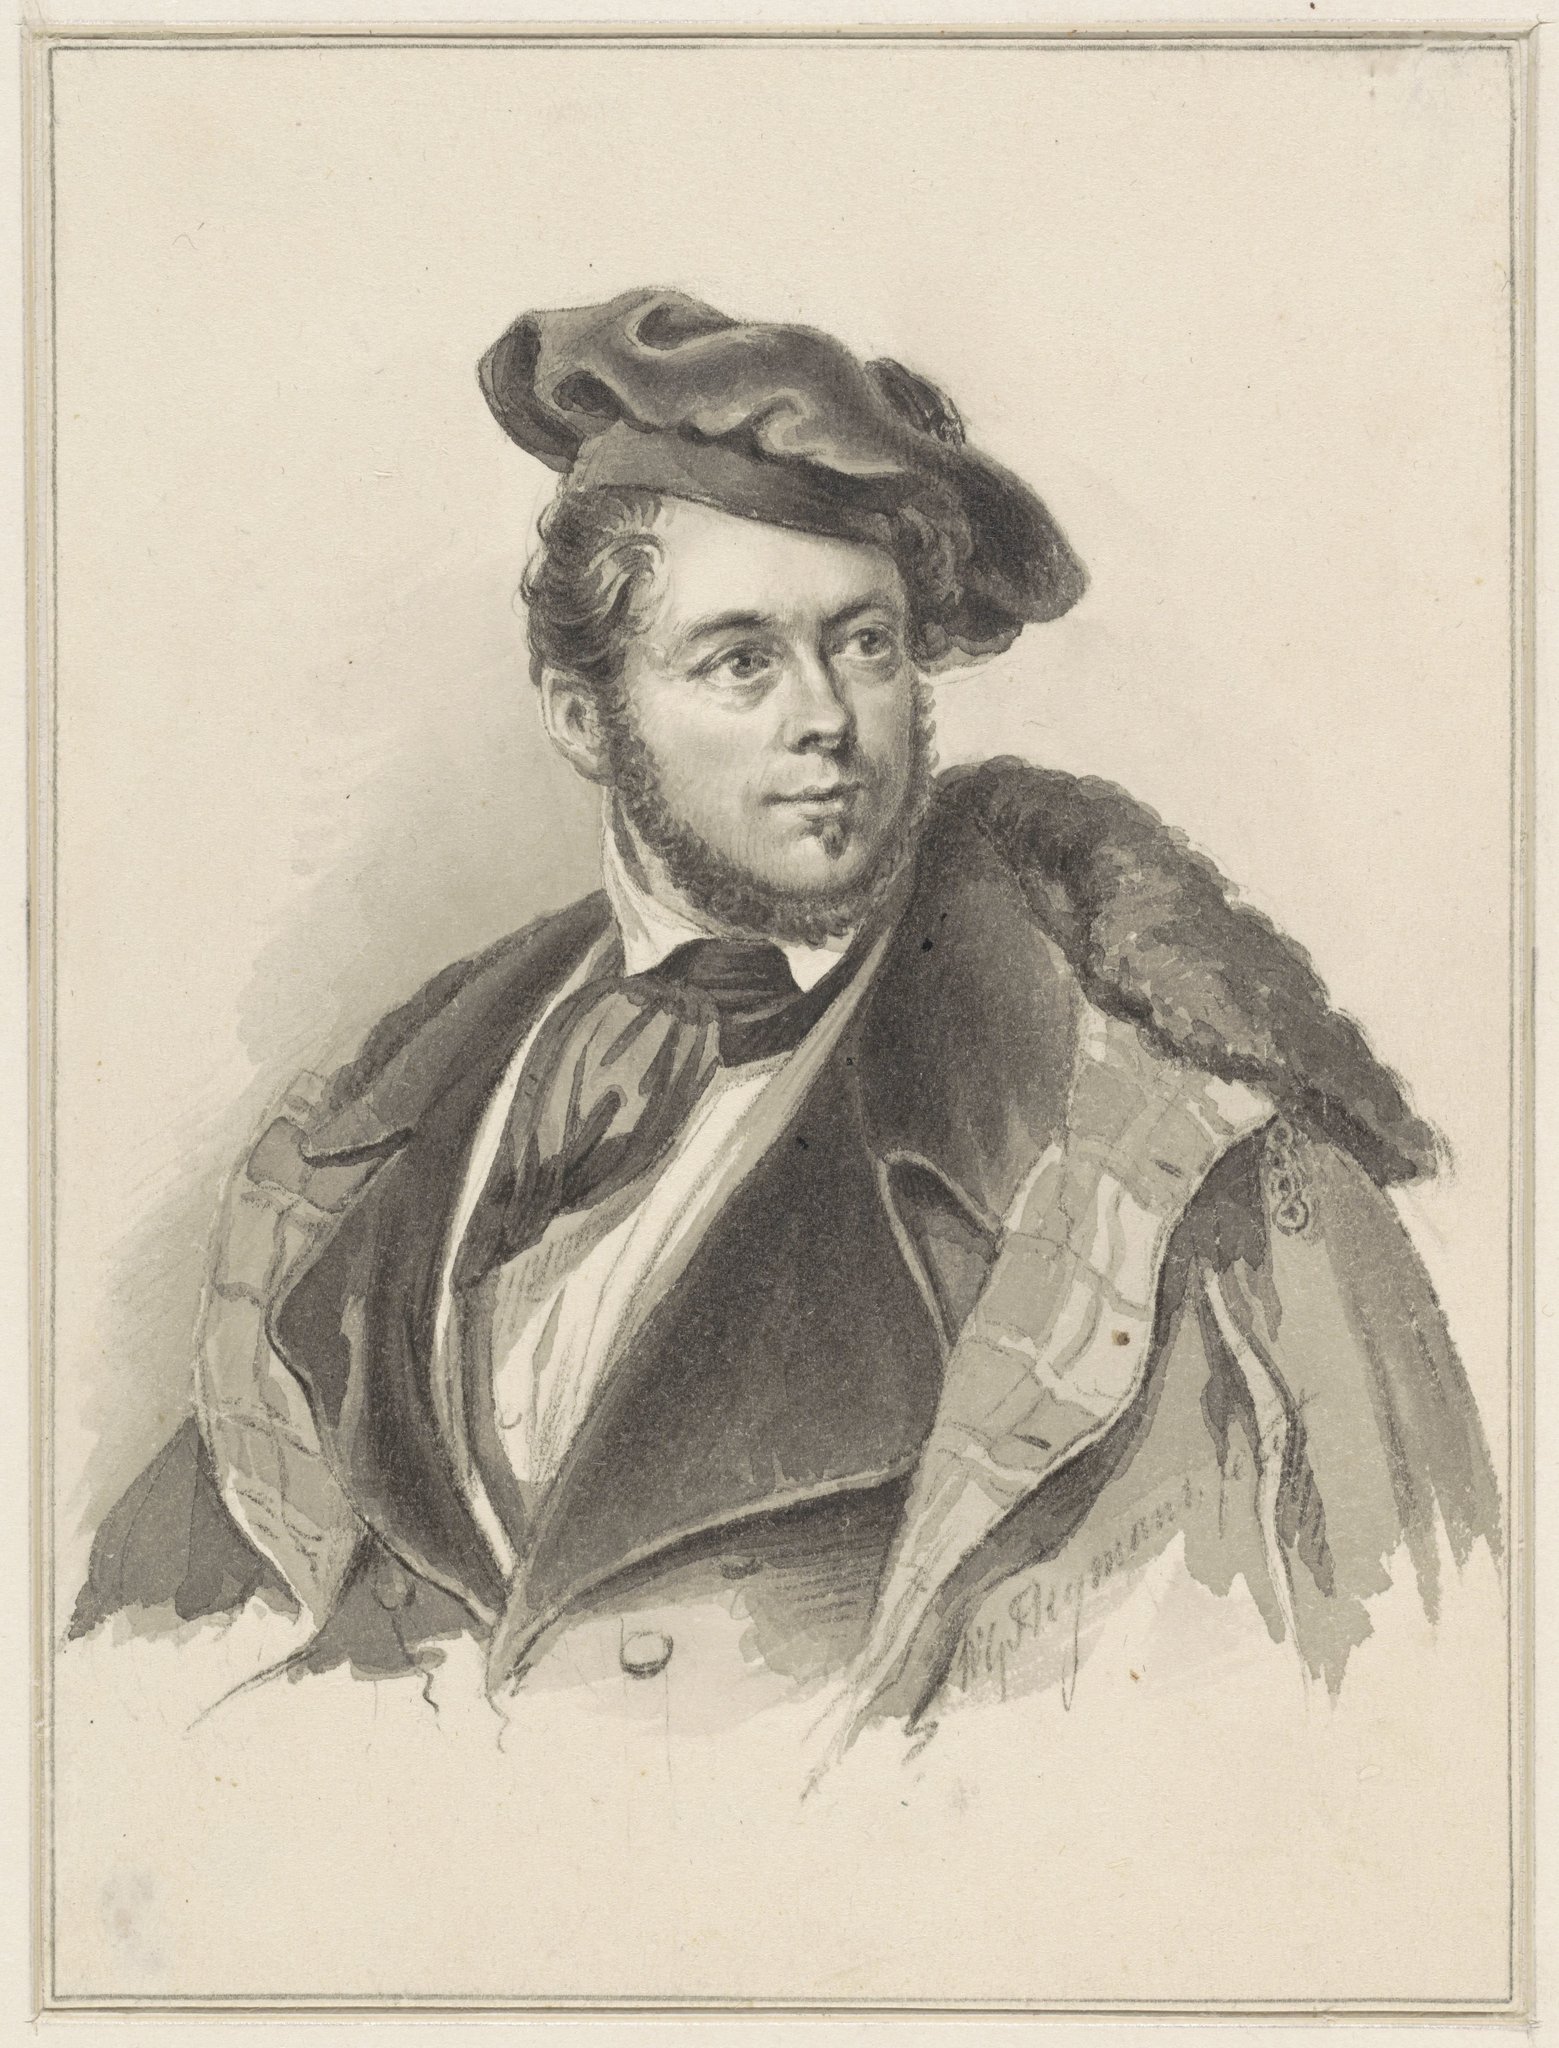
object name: drawing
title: Zelfportret van Willem George Frederik Heijmans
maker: willem george frederik heijmans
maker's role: draughtsman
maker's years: 1799-1867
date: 1825-1868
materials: paper, watercolor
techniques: brush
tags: the hague, draughtsman, willem george frederik heijmans, historical persons, portrait, self-portrait of painter, portrait, self-portrait of artist, portrait, self-portrait of draughtsman